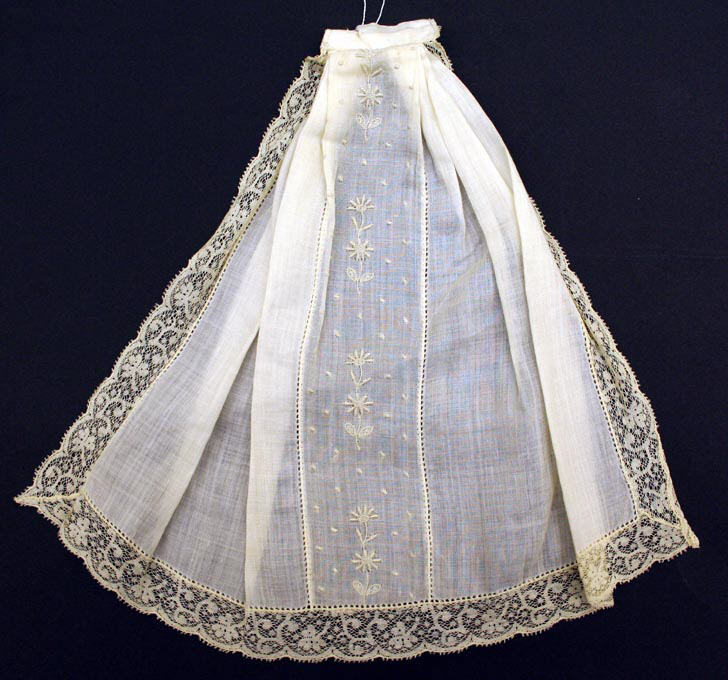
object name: jabot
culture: american or european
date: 1700-1940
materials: cotton